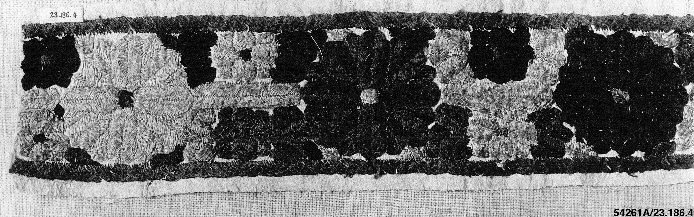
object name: band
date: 1801-1833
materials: cotton, silk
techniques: embroidery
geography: morocco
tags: flowers